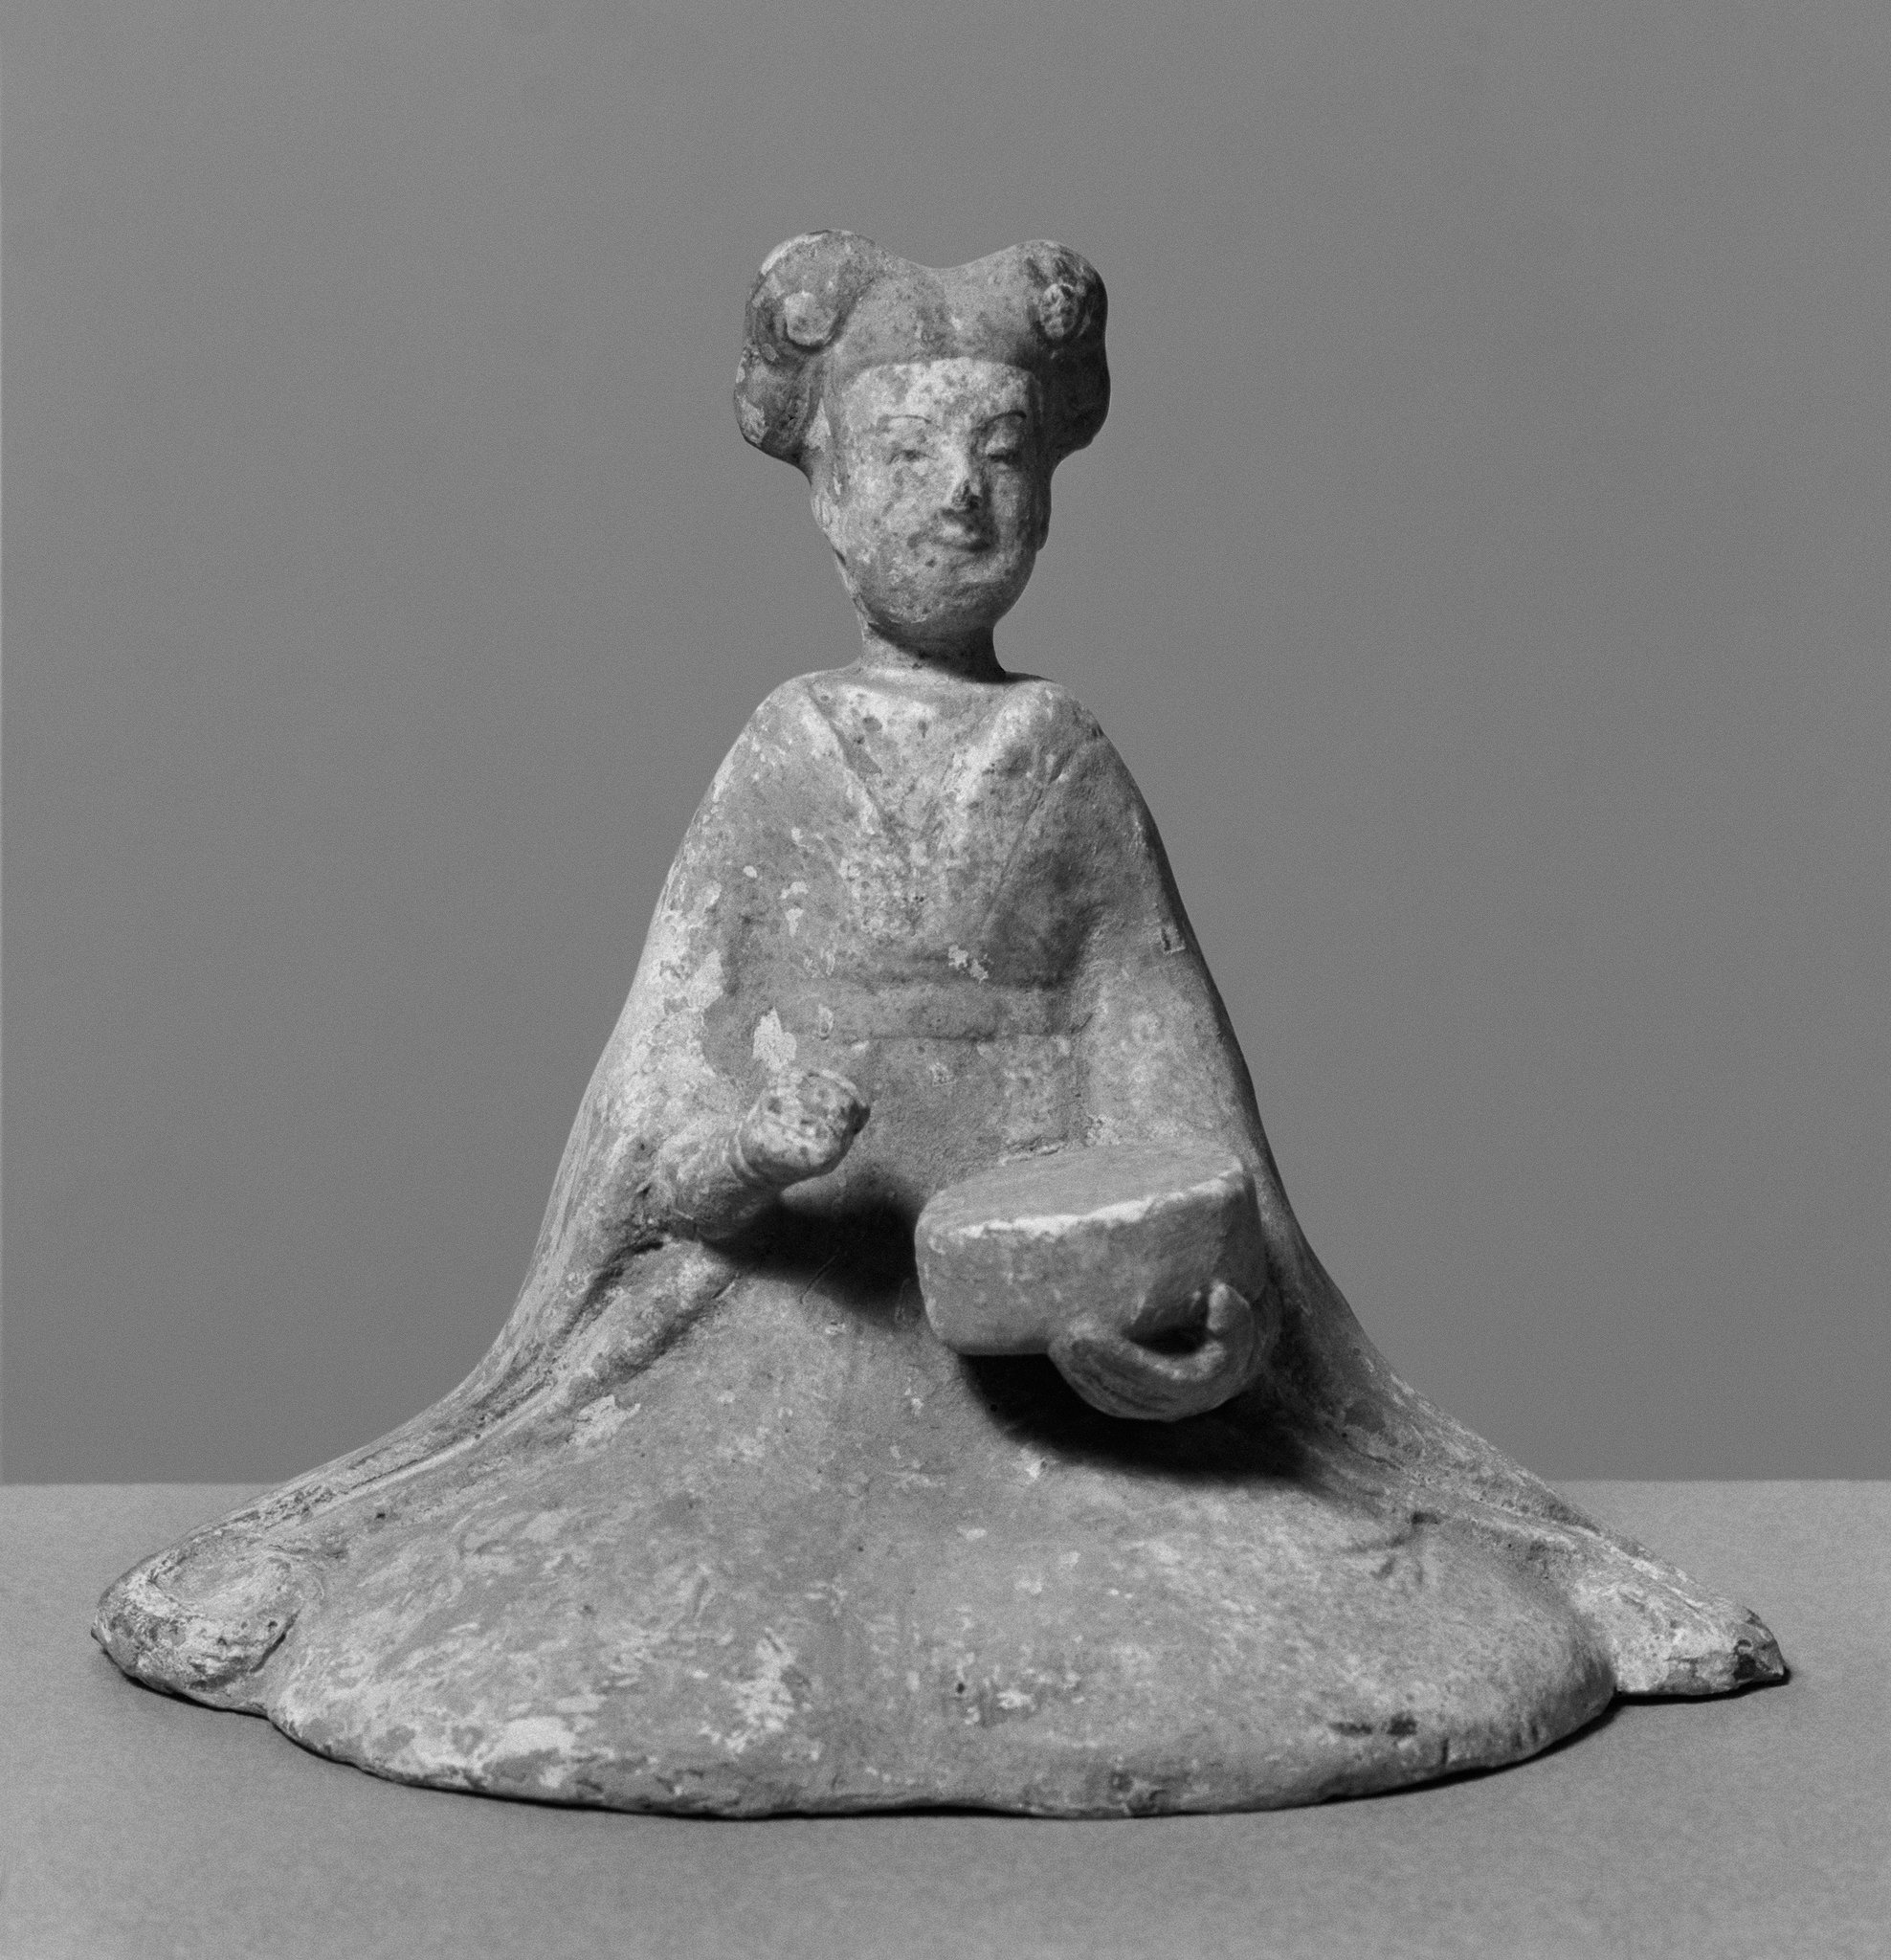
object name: figure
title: Female musician with drum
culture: chinese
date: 501-700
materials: earthenware, pigment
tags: musicians